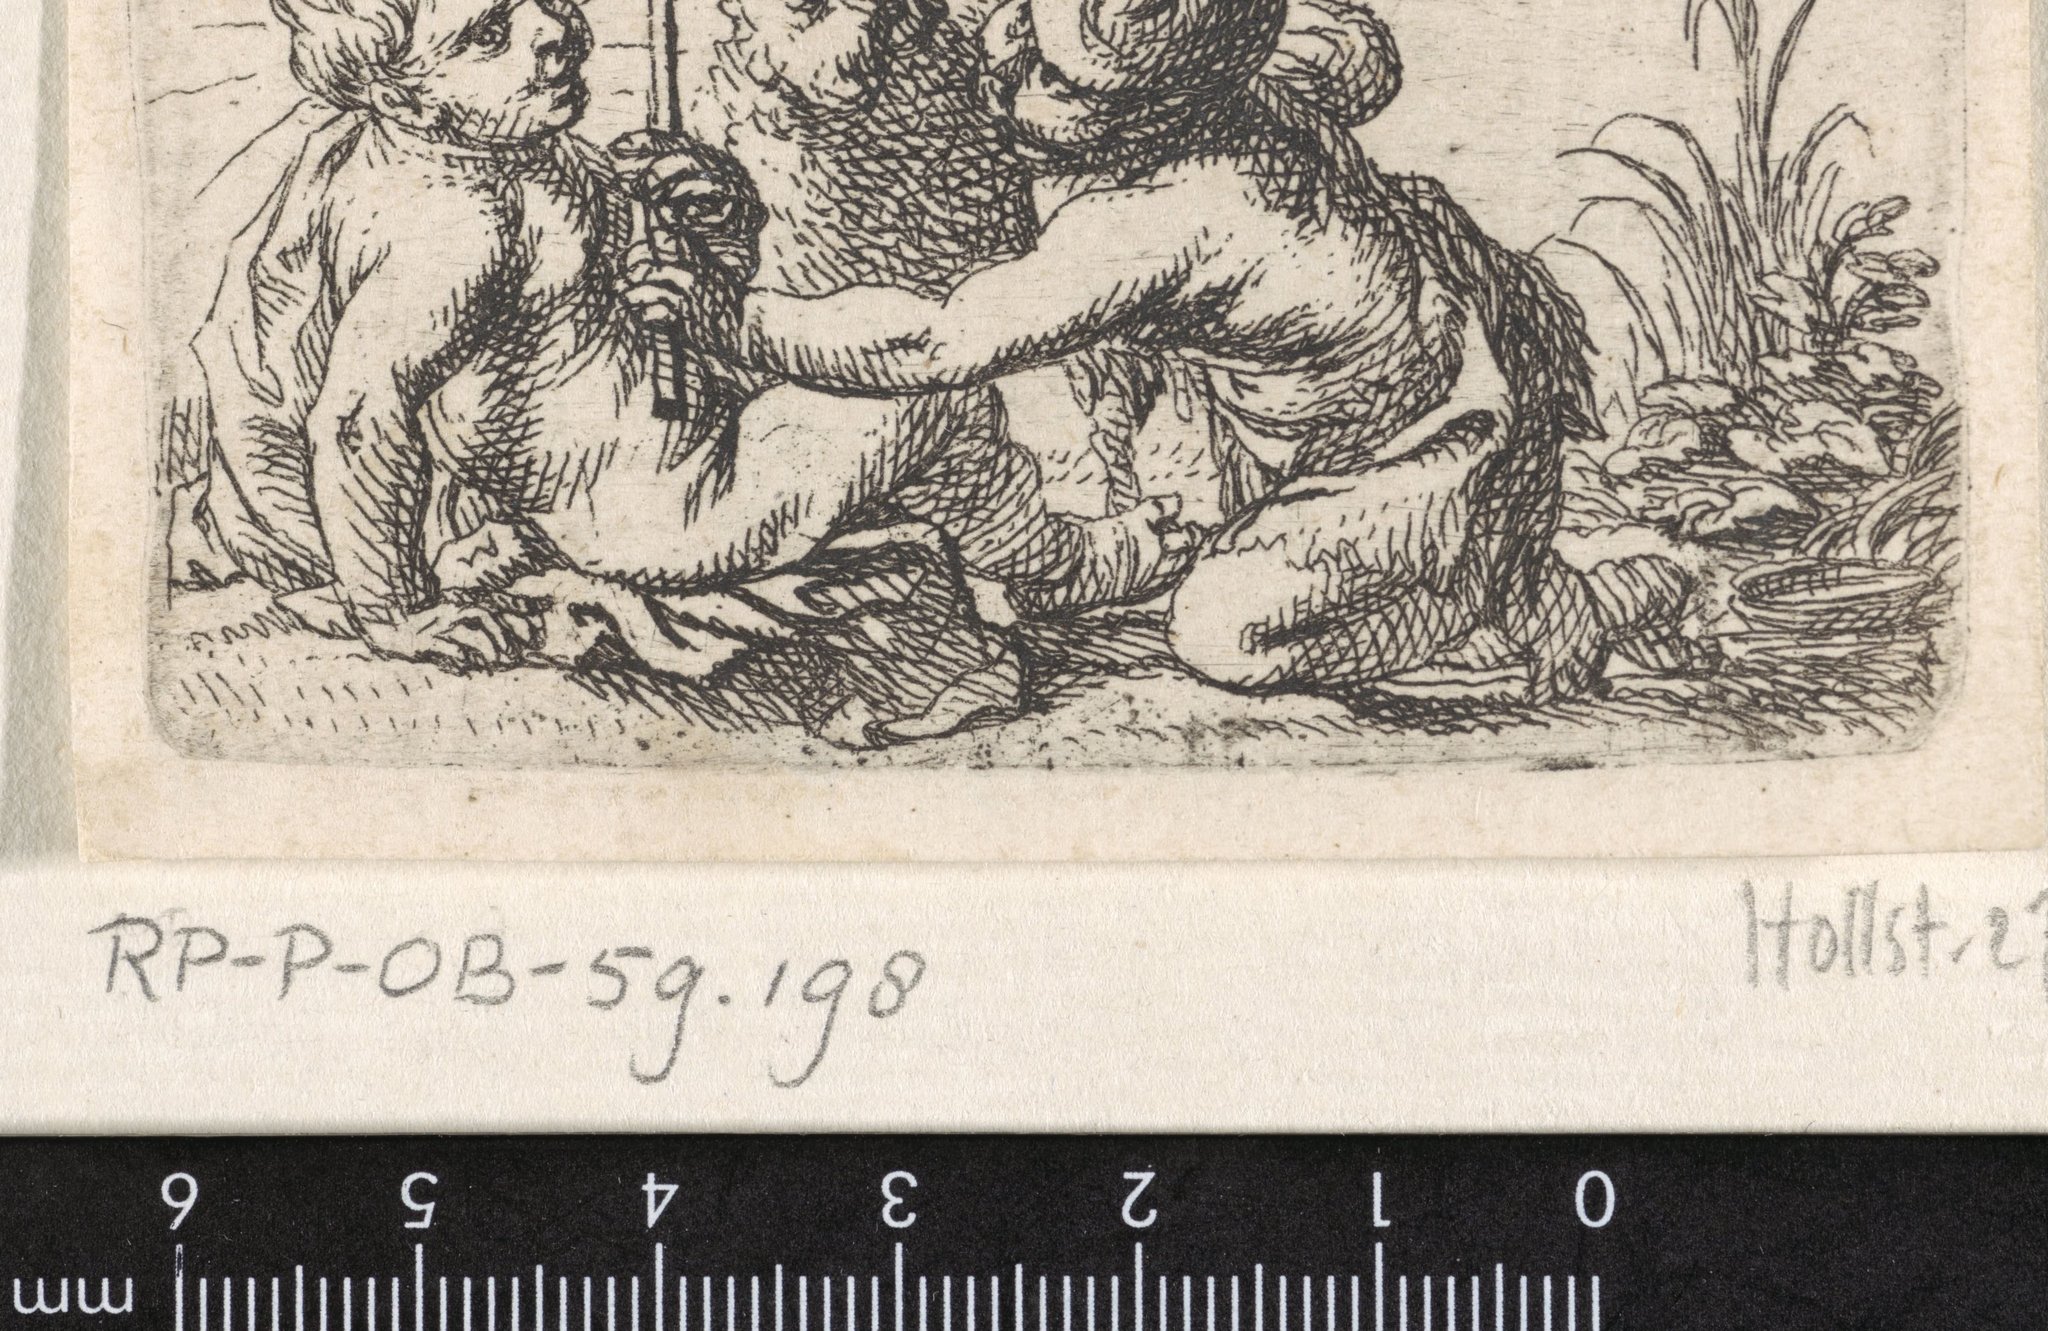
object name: print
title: Christuskind en Johannes de doper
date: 1618-1655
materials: paper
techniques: etching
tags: the christ-child and john the baptist (as child)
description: Het Christuskind en de jonge Johannes de Doper zitten op de grond. . Zij houden een overwinningsbanier vast met daarop de tekst 'Ecce agnus'. Het lam staat tussen hen in.